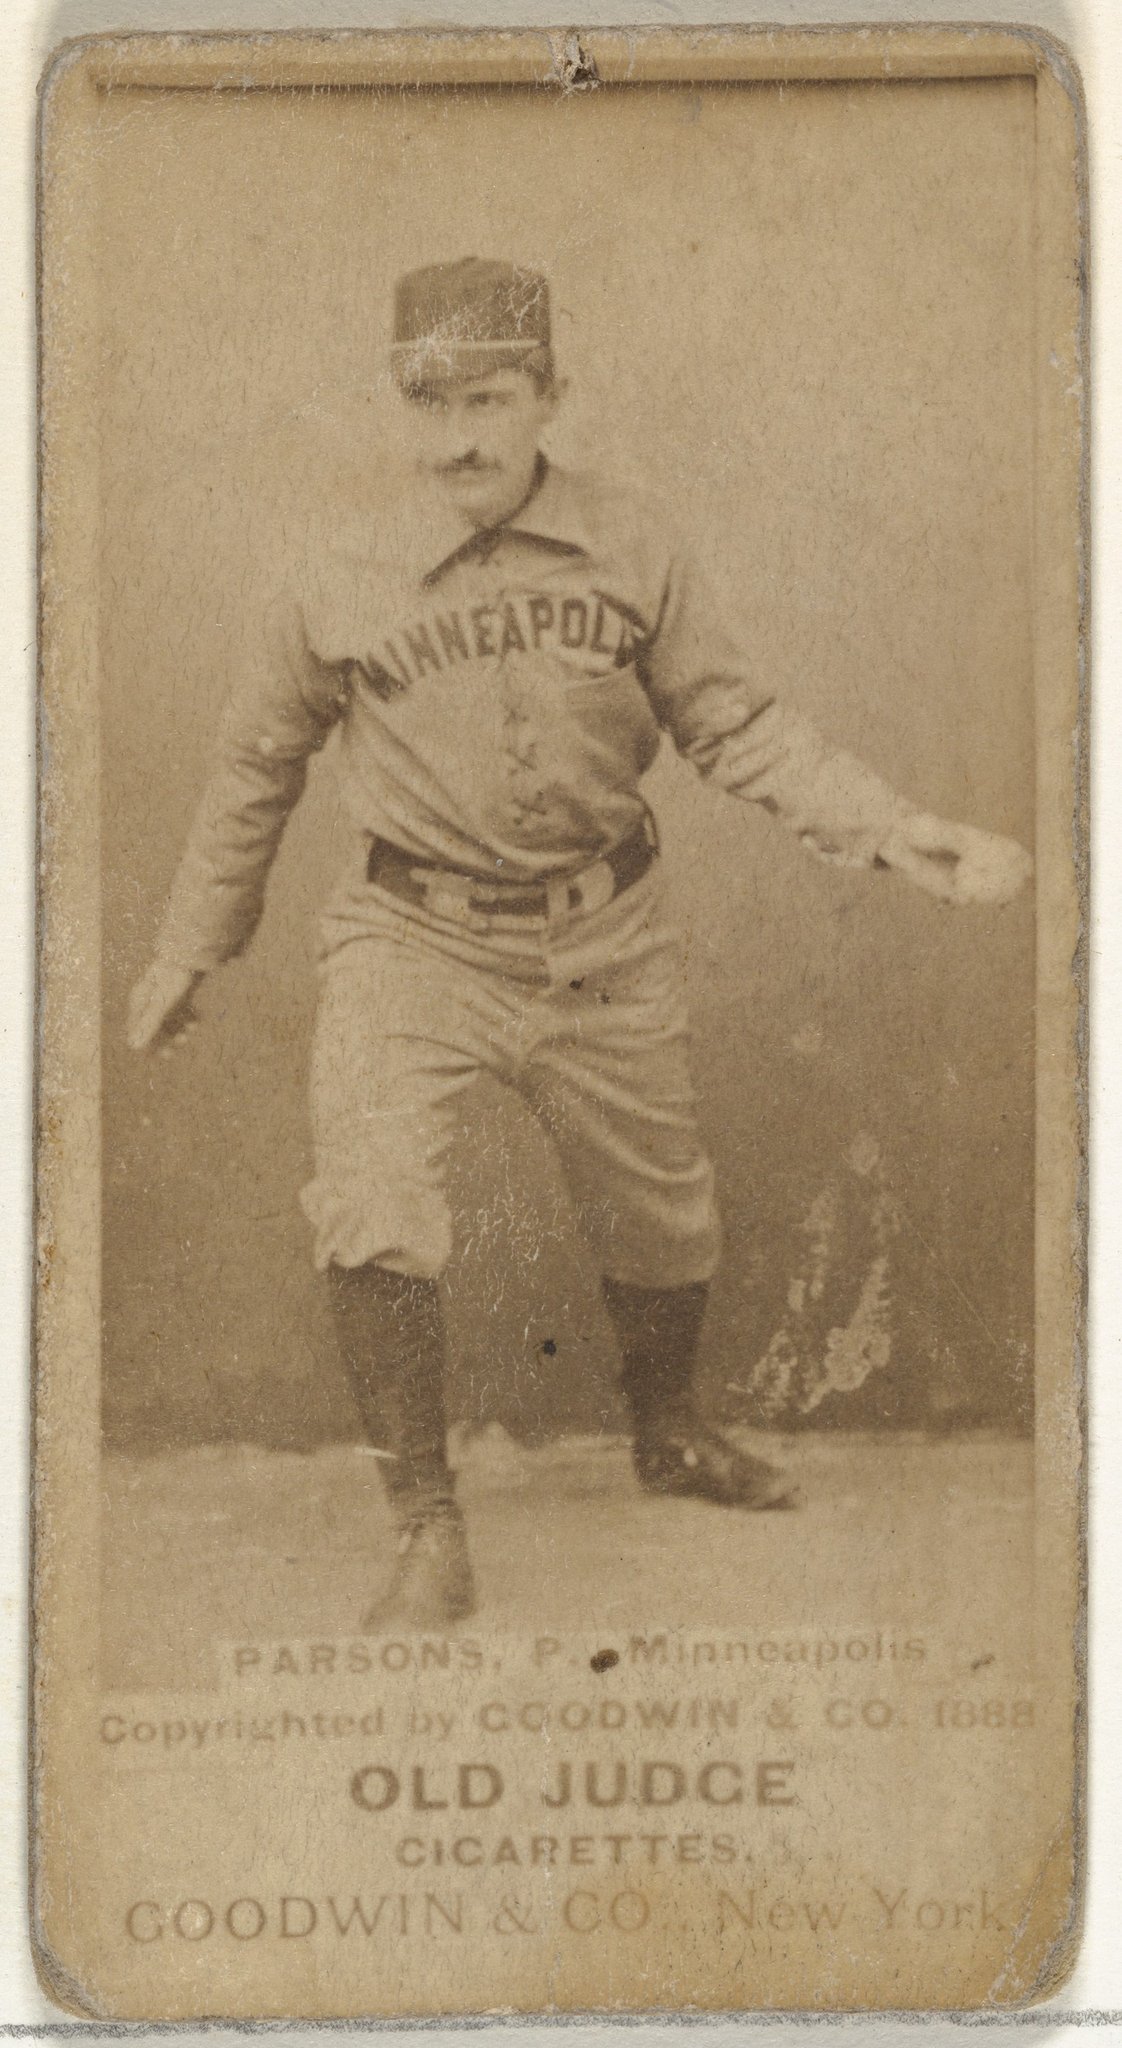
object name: baseball card, photograph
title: Charles James "Charlie" Parsons, Pitcher, Minneapolis, from the Old Judge series (N172) for Old Judge Cigarettes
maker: goodwin & company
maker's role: publisher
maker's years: 1850-1950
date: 1888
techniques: albumen silver print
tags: men,portraits,baseball,athletes